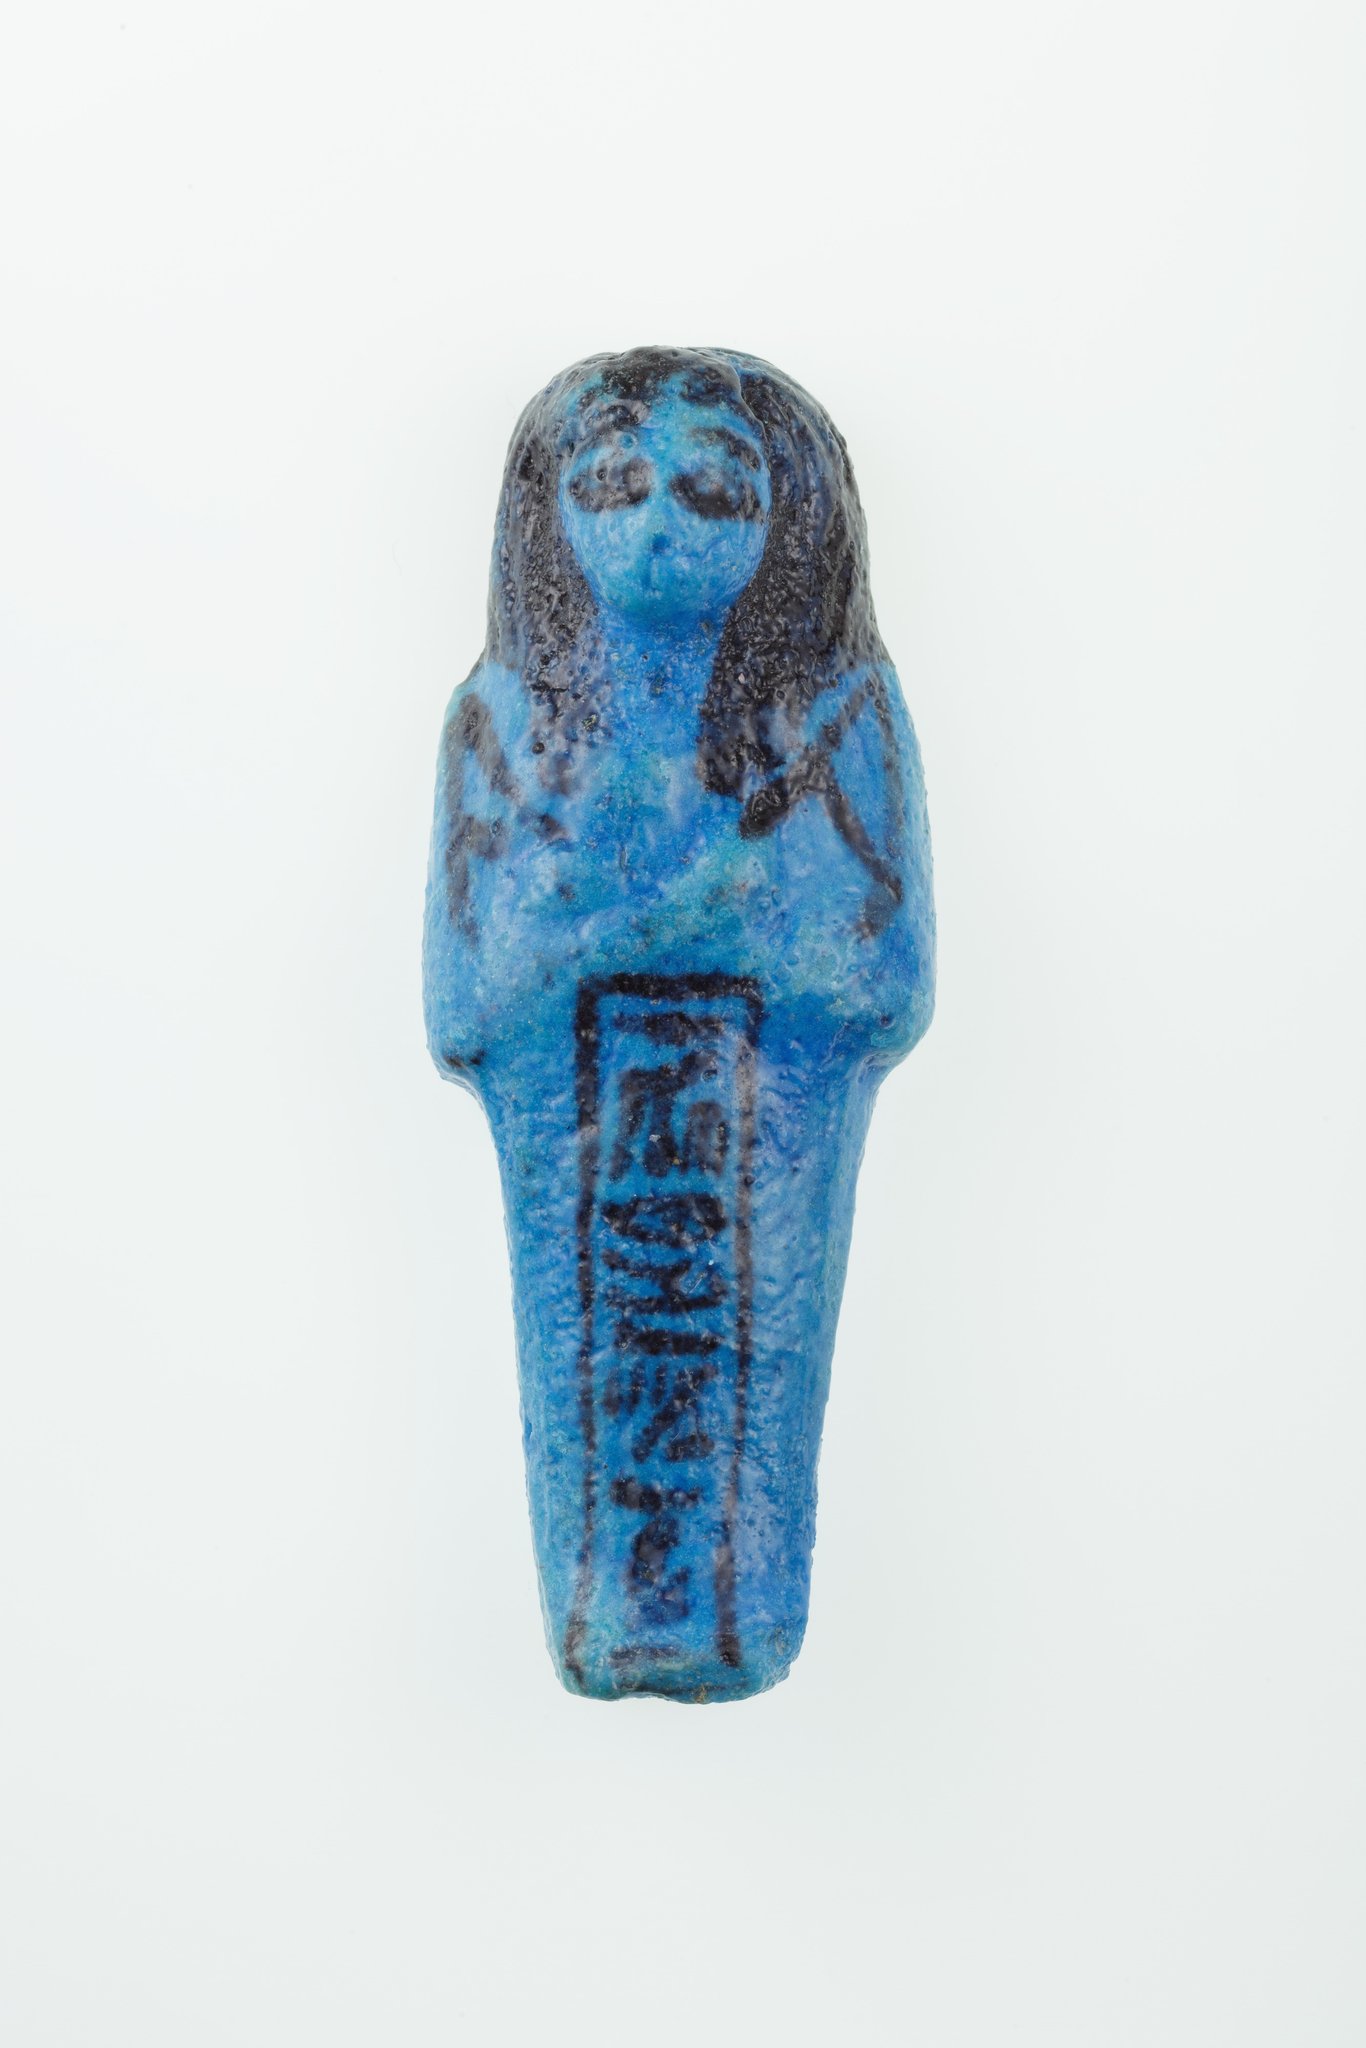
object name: shabti, worker, nauny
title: Worker Shabti of Nauny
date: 1050 BCE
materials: faience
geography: egypt